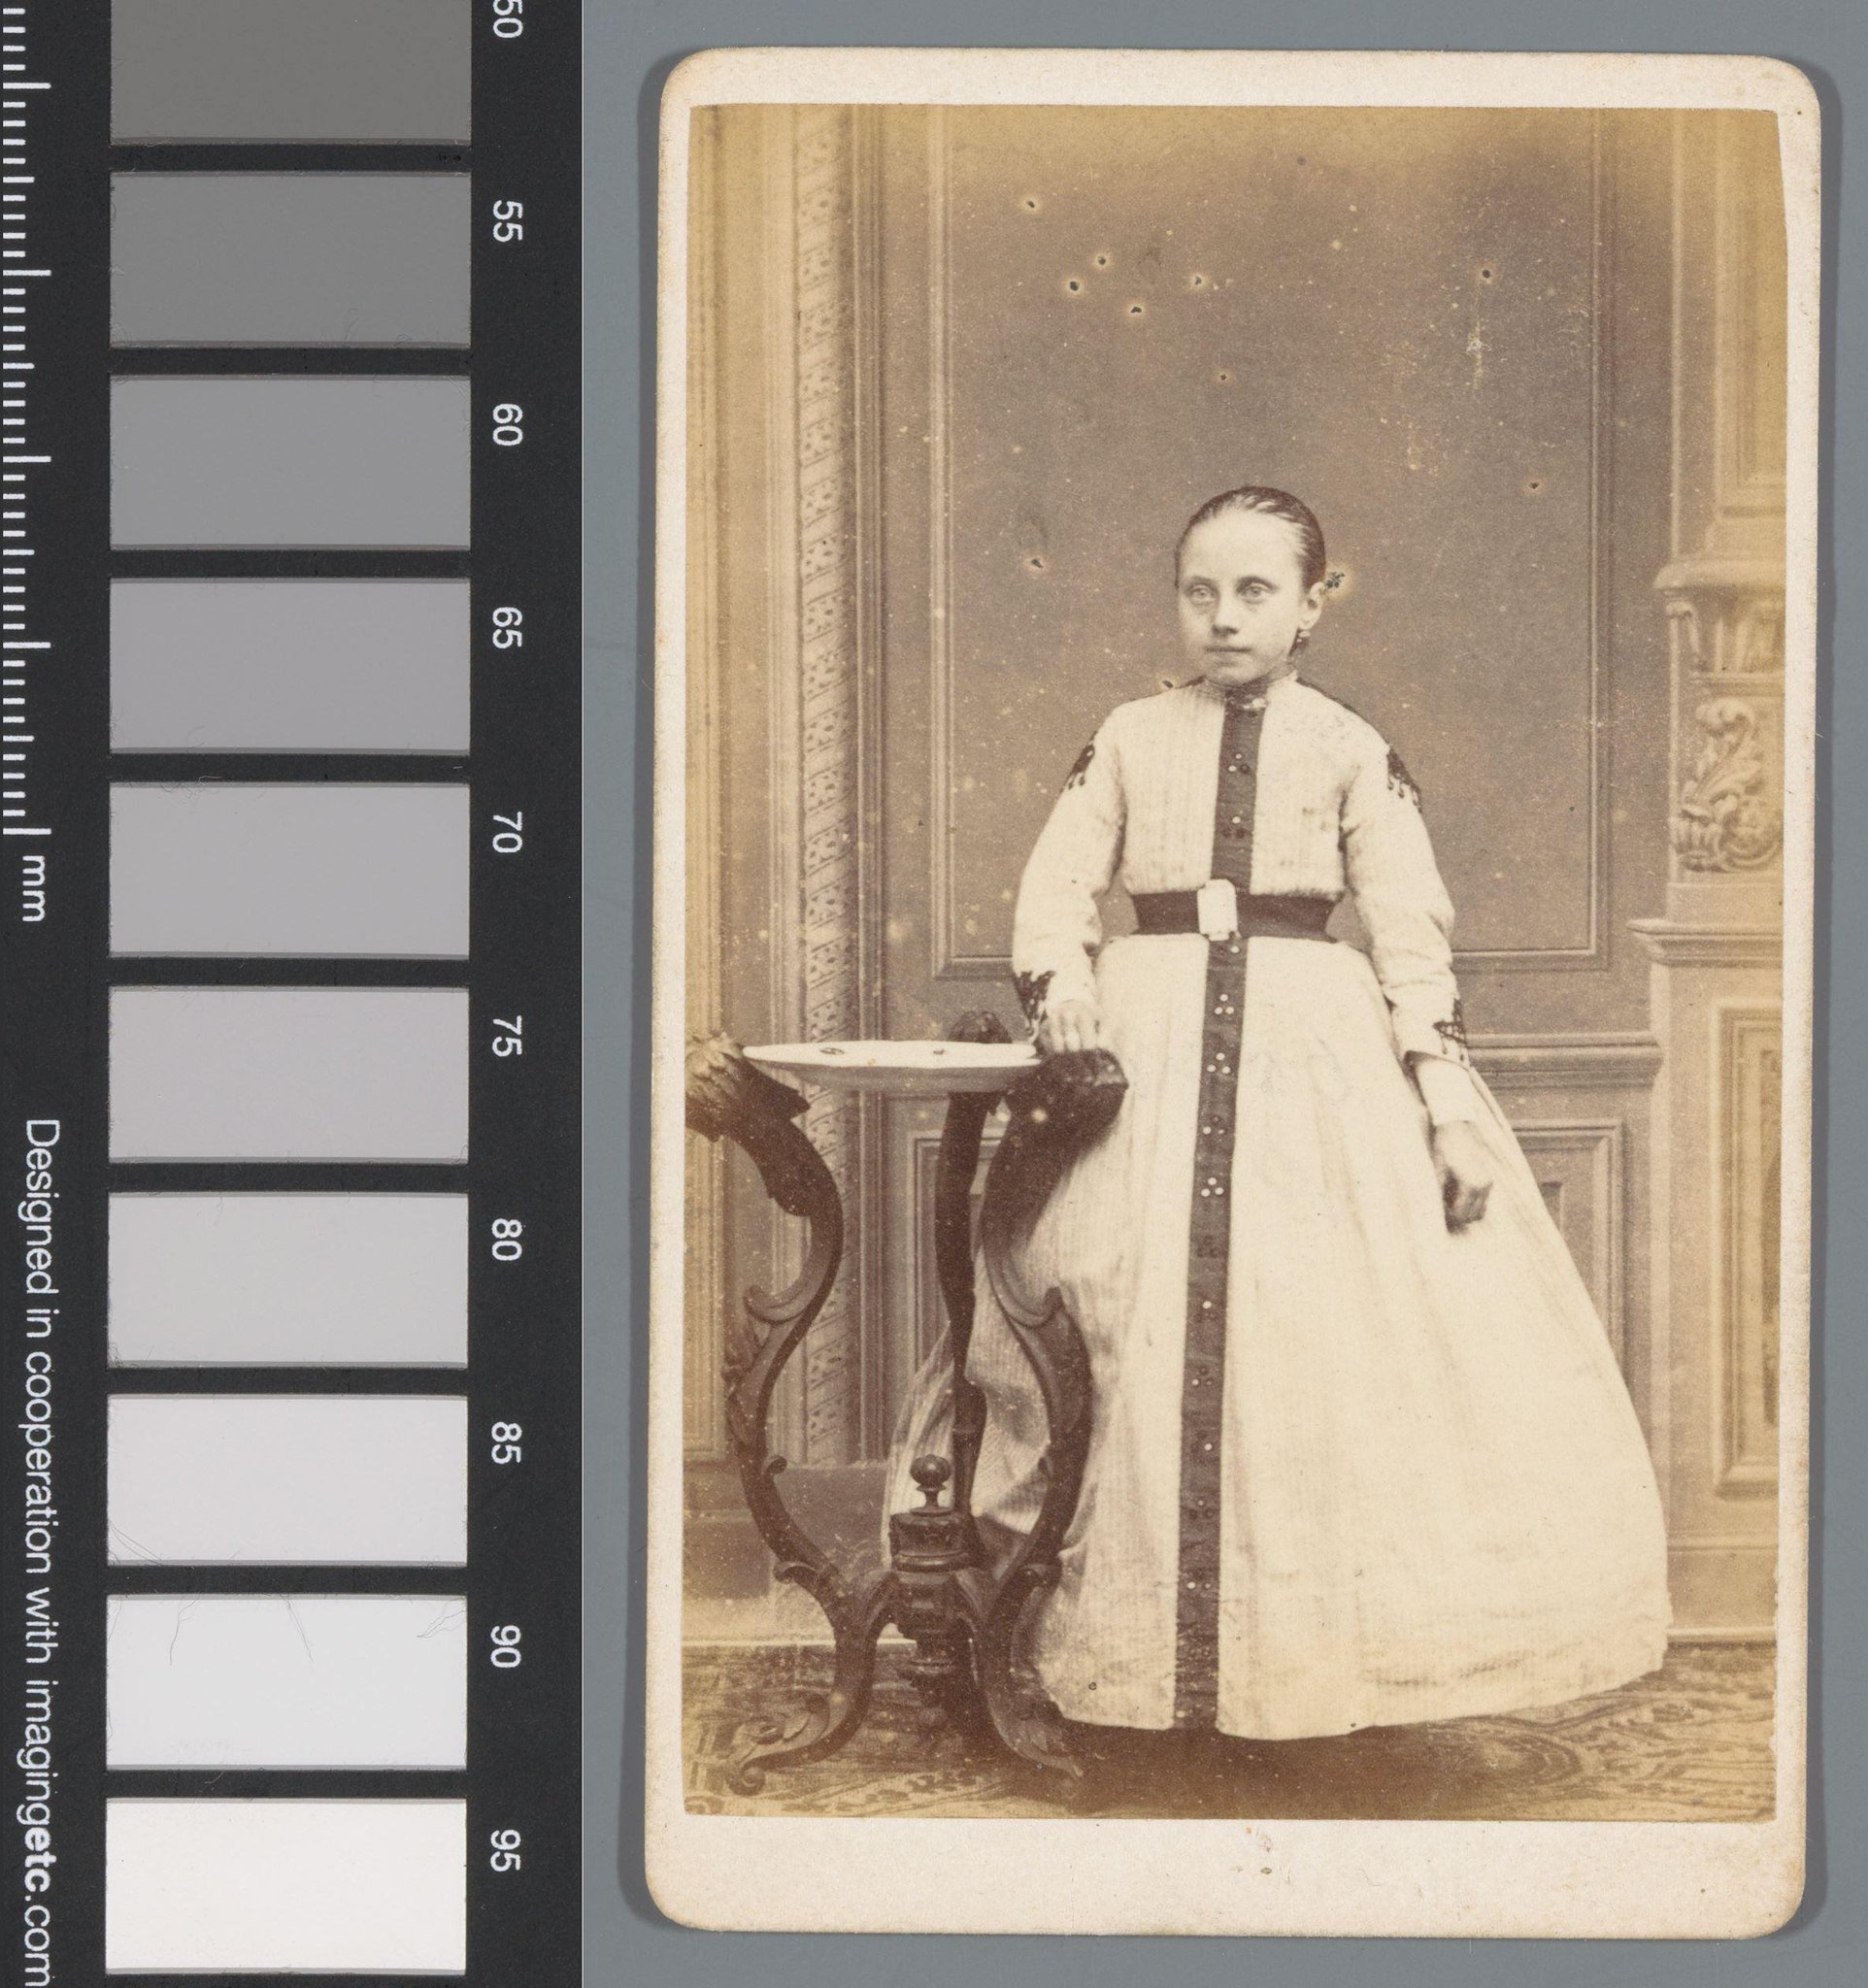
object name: carte de visite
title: Portret van een onbekend meisje, staande naast een tafel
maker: johannes frederik hulk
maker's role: draughtsman, painter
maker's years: 1829-1911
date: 1864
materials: cardboard, paper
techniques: albumen print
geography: amsterdam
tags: historical persons, girl (child between toddler and youth), table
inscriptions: number: ‘6435’, stamp: ‘ATELIER REMBRANDT/ H./ J. F. HULK/ AMSTERDAM/ ROKIN E 167.’